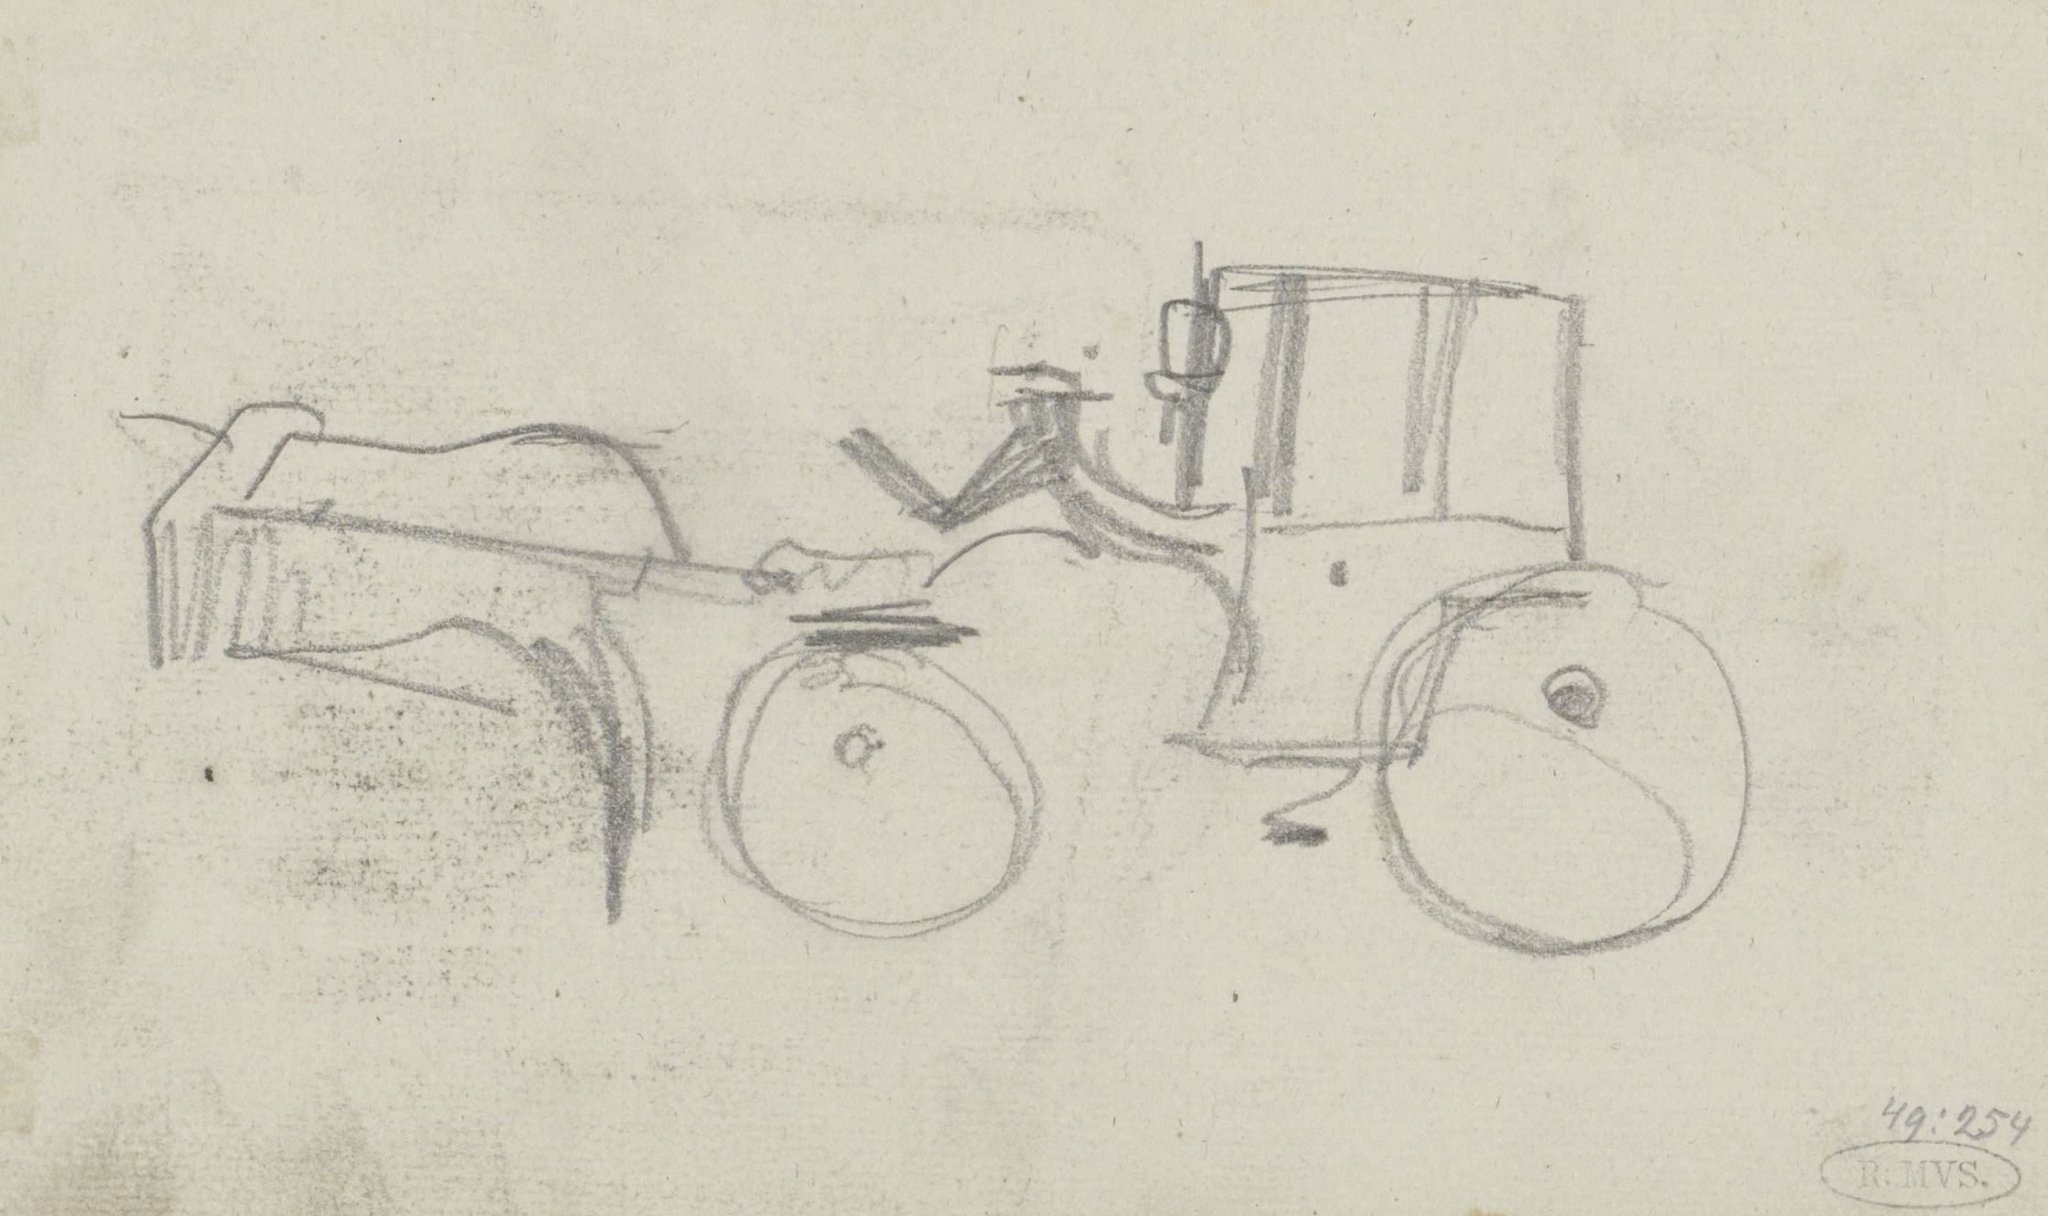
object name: drawing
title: Rijtuig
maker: george hendrik breitner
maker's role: draughtsman, painter, print maker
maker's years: 1857-1923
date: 1882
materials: paper, pencil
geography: amsterdam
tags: four-wheeled, animal-drawn vehicle, e.g.: cab, carriage, coach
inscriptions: collector's mark: Lugt 2228